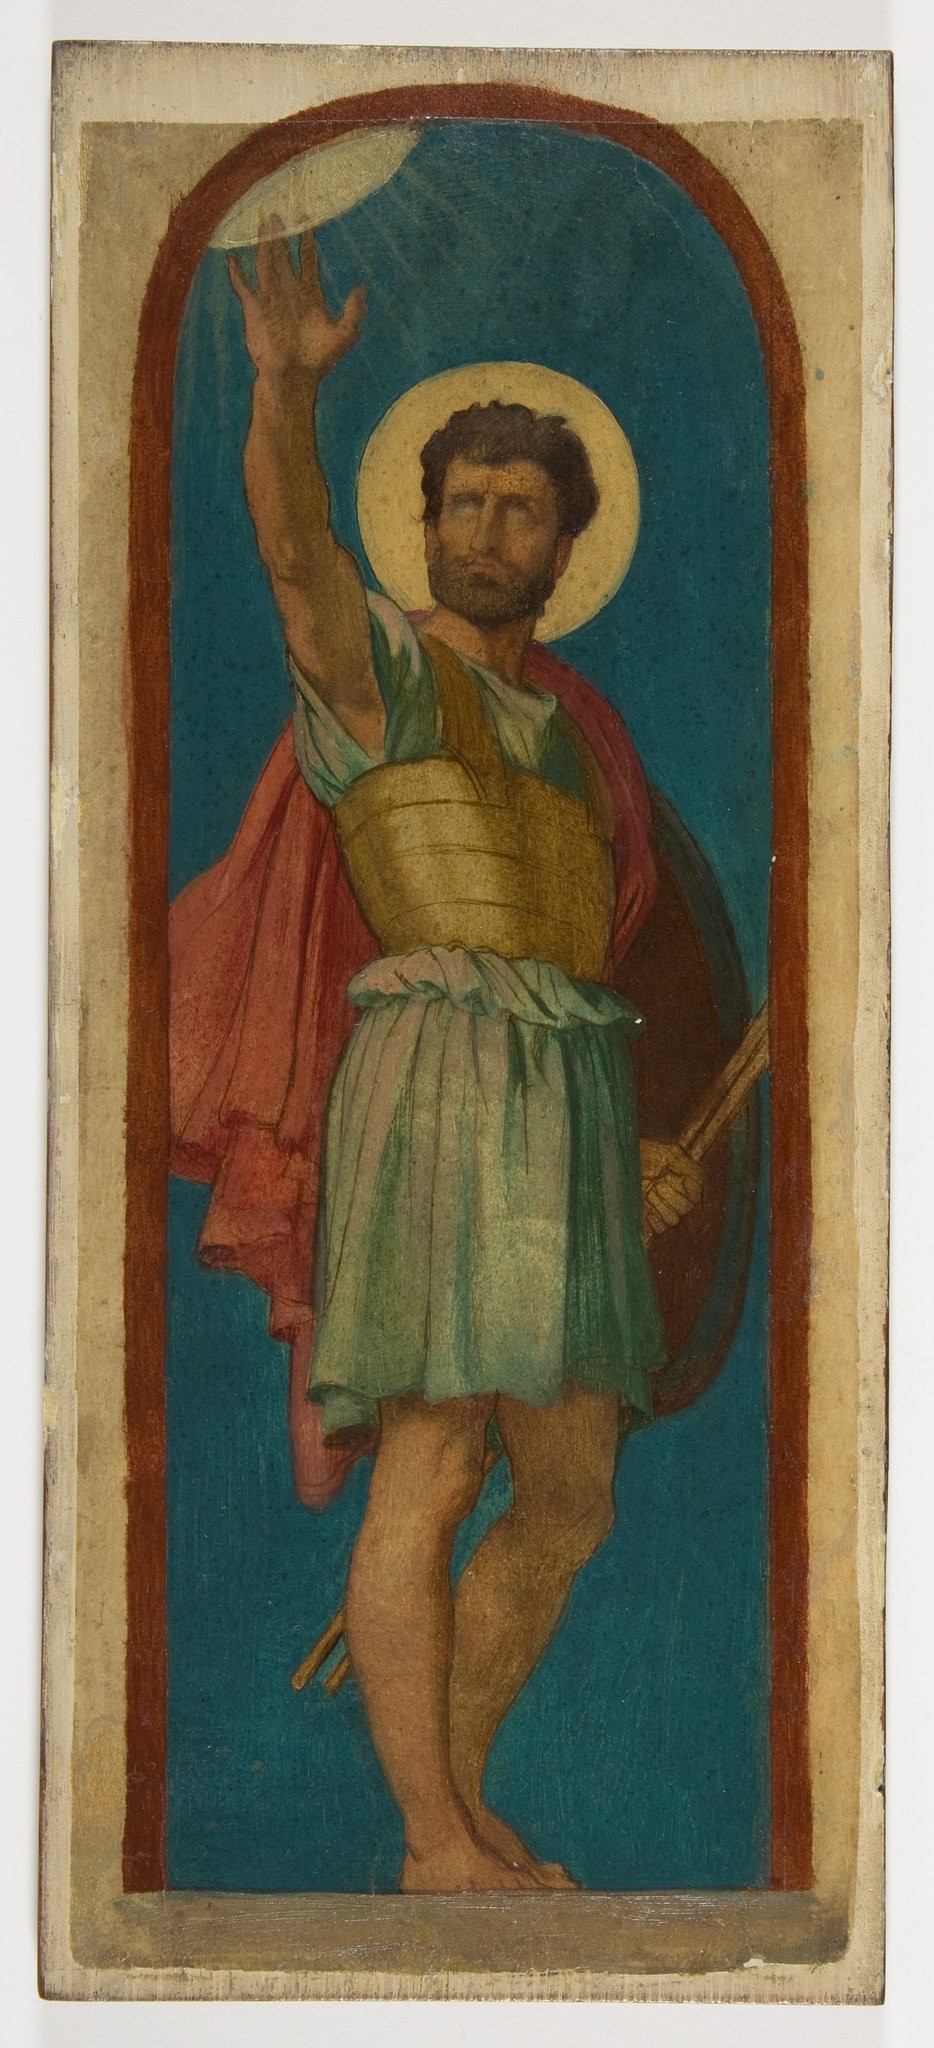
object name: drawing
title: Joshua, with the Sun at Upper Left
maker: hippolyte flandrin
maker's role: artist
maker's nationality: french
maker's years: 1809-1864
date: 1856-1863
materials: ink, oil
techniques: pen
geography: france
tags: sun,joshua